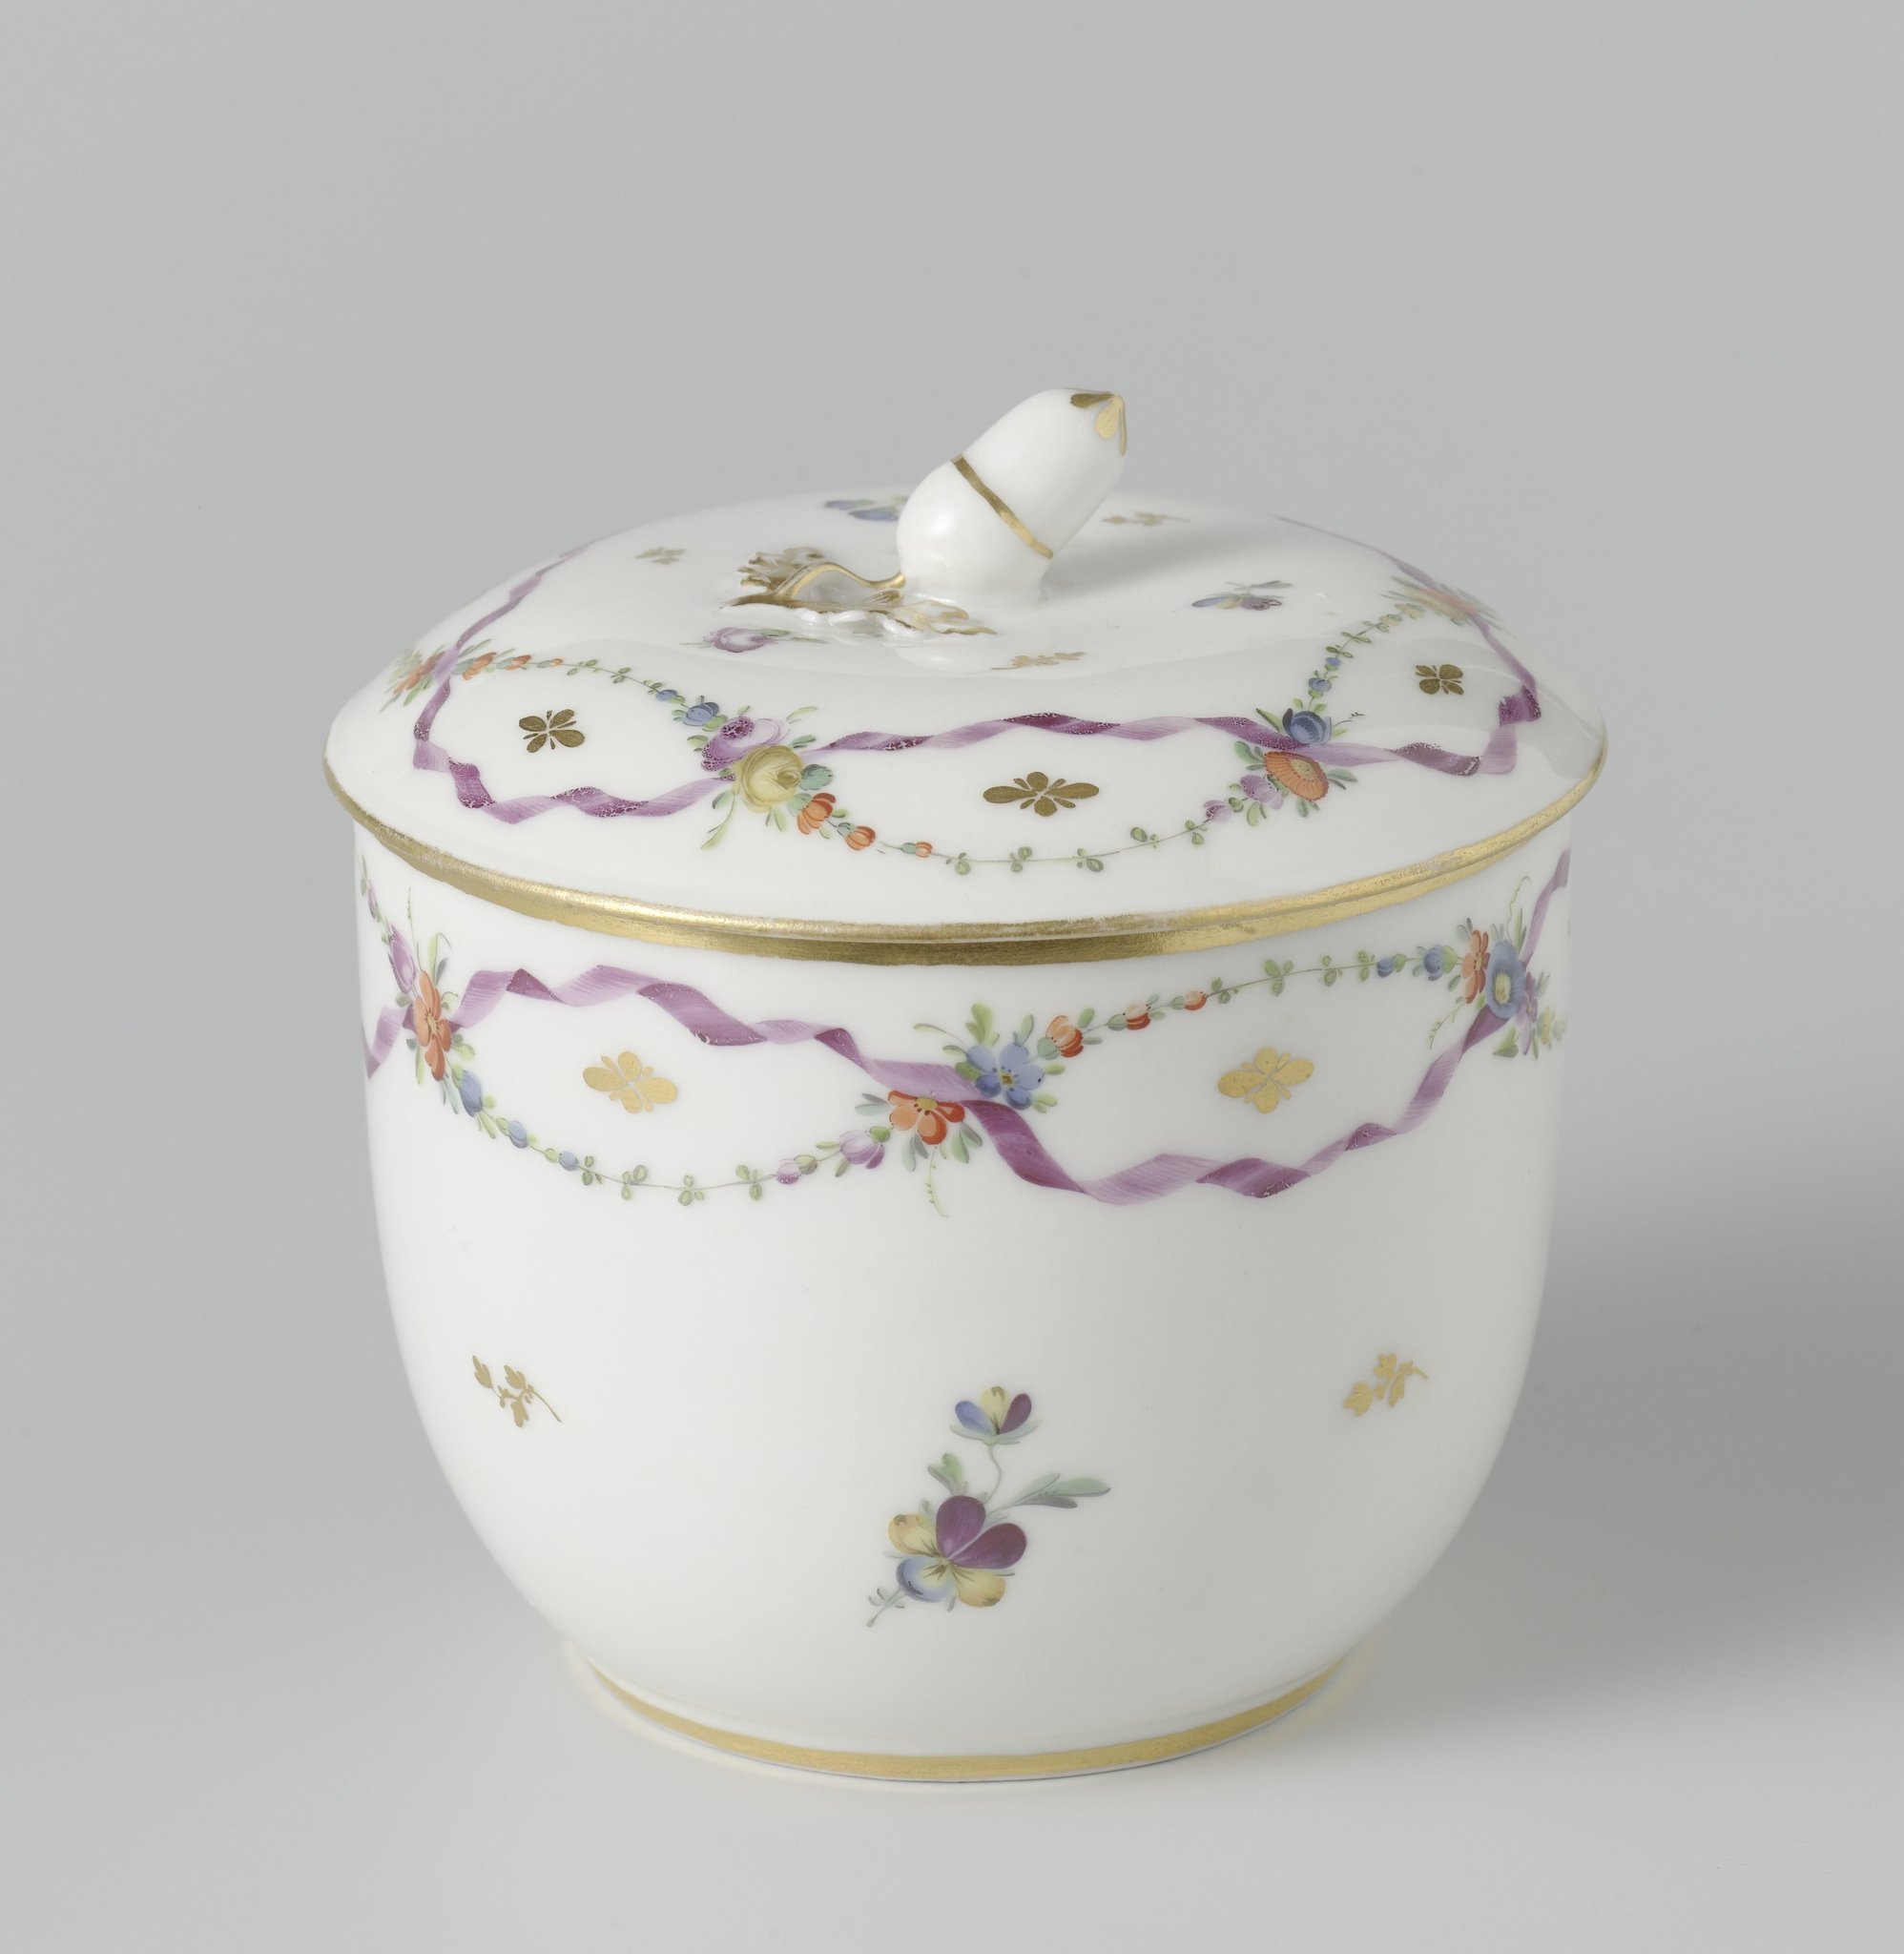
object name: sugar box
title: Suikerpot, beschilderd met strooibloemen en gouden lovertjes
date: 1809-1814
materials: porcelain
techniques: painted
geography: nieuwer-amstel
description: Tea service. Porcelain. Ouder-Amstel, c. 1790 - 1800. Factory under the direction of Friedrich Daeuber. Given by Mr and Mrs J.F. Heijbroek-Leendertz, 1985.